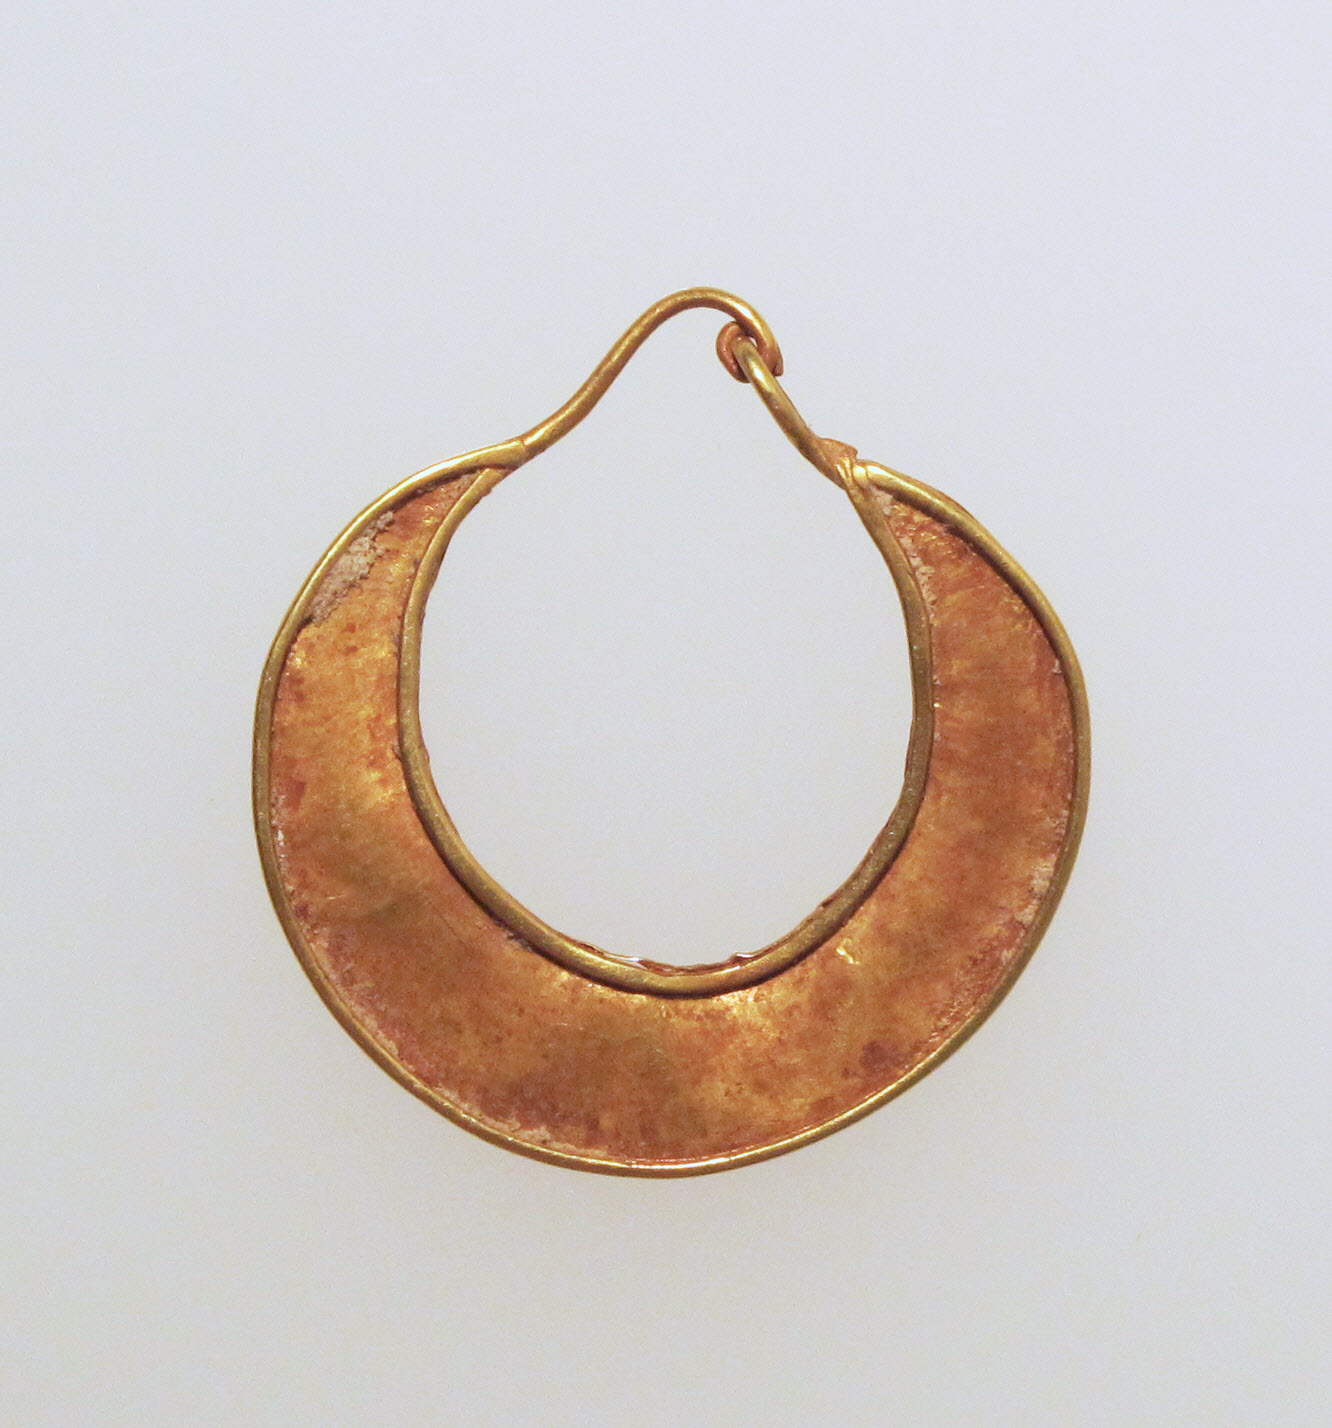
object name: earring, crescent shaped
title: Earring, crescent-shaped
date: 7000 BCE-330 CE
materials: gold